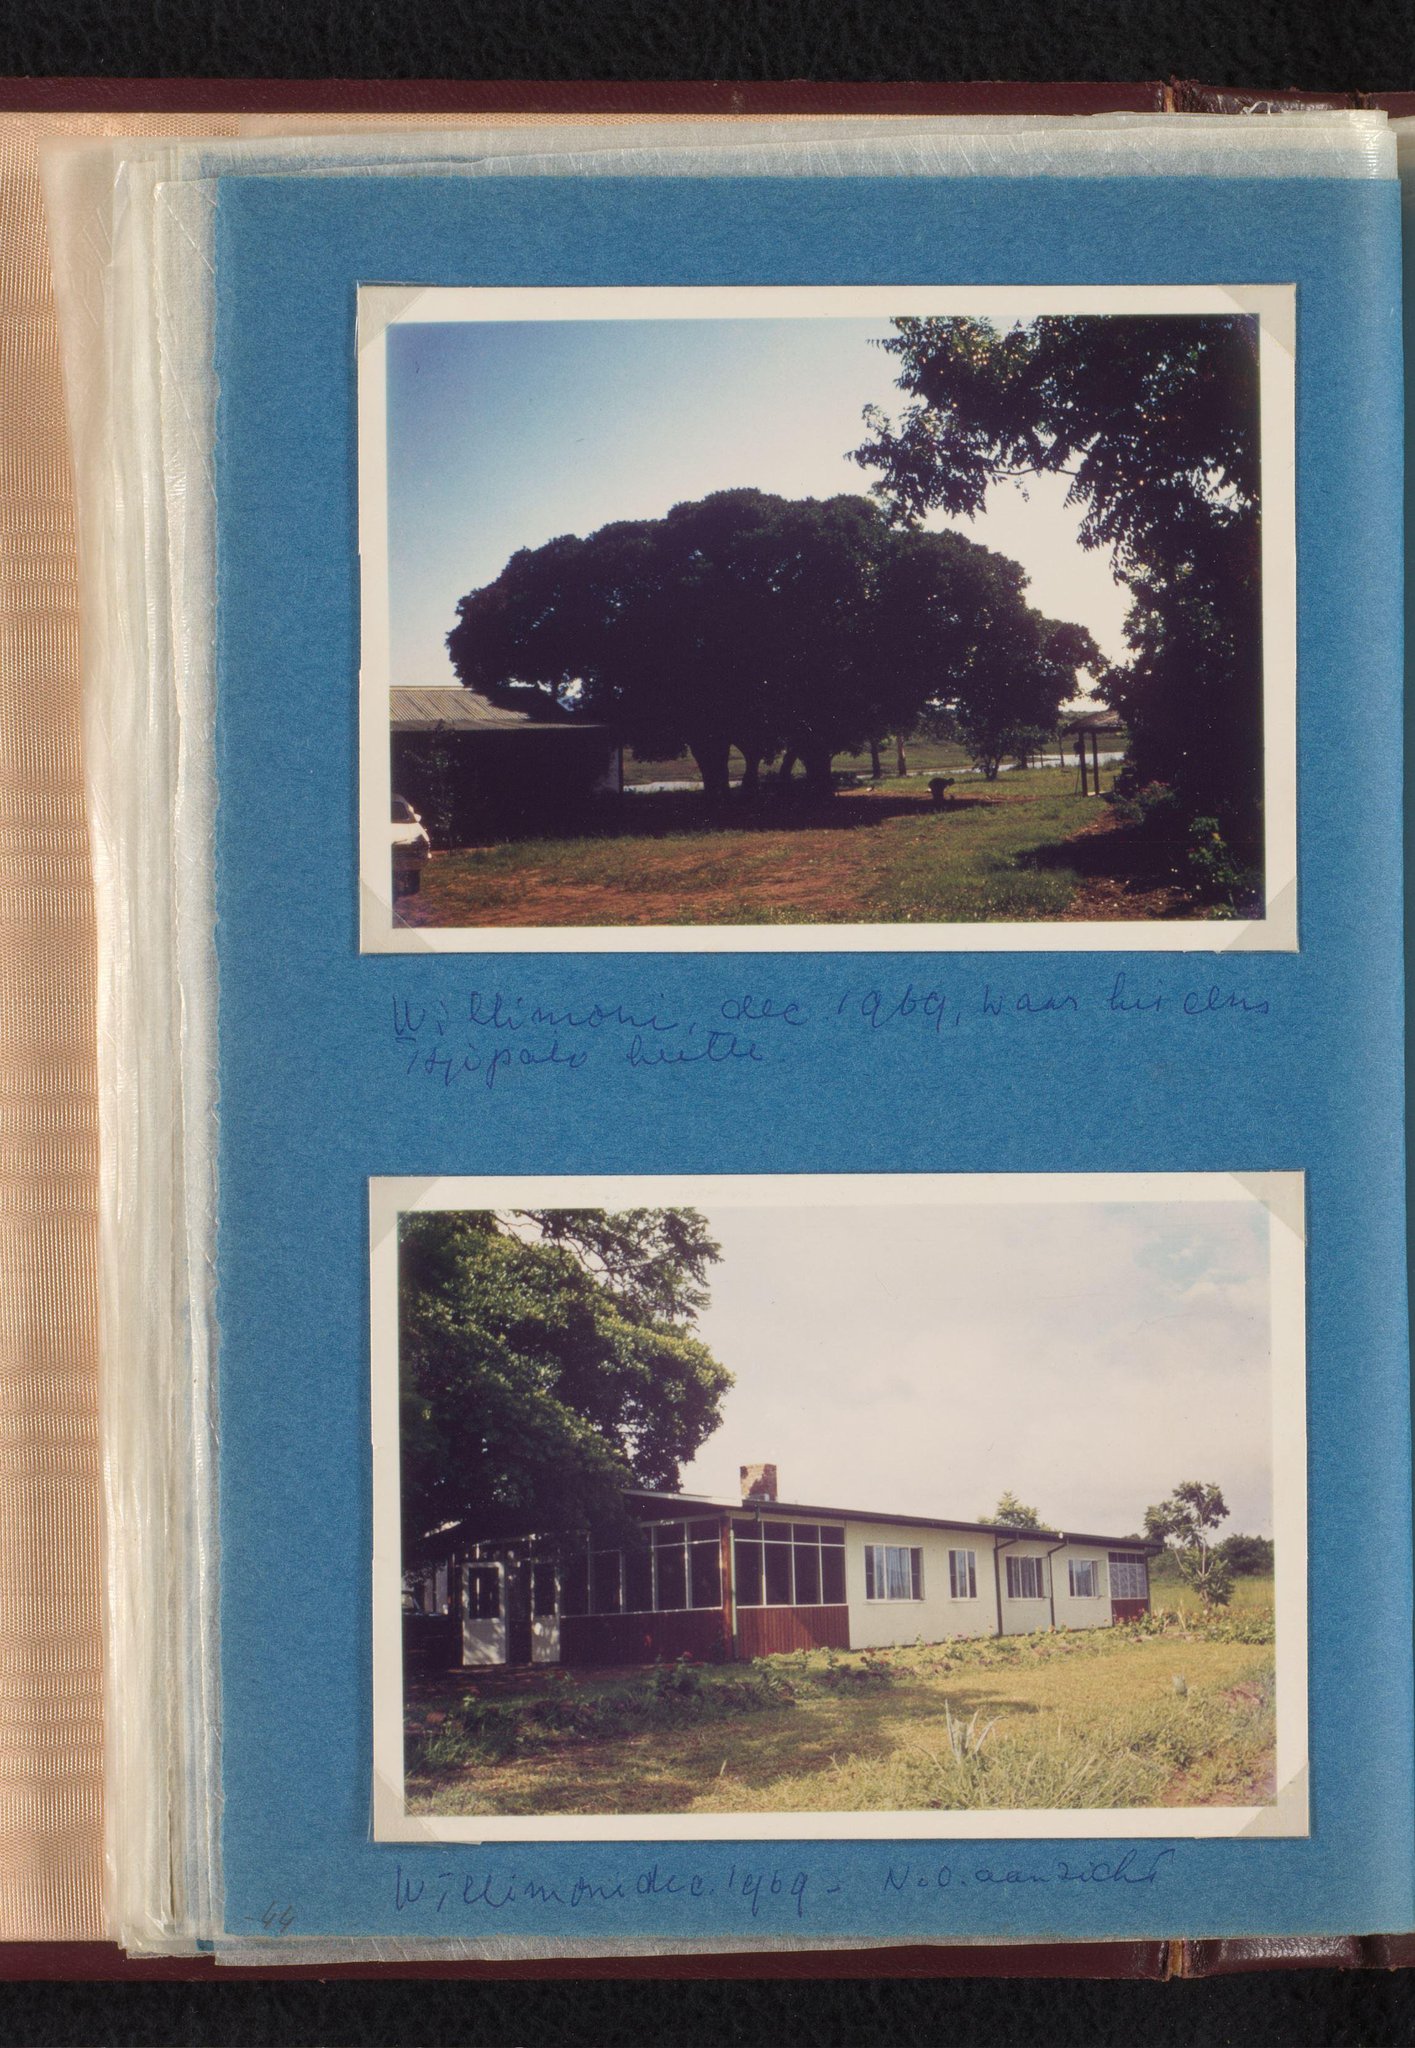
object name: photograph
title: Woonhuis van Willem van den Berg in Shewasaulu, Zuid-Afrika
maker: willem jacob van den berg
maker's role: boer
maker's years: 1902-1983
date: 1912-1969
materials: paper, cardboard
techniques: chromogenic print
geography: shewasaulu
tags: civic architecture; edifices; dwellings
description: Deze foto's zijn onderdeel van een album.